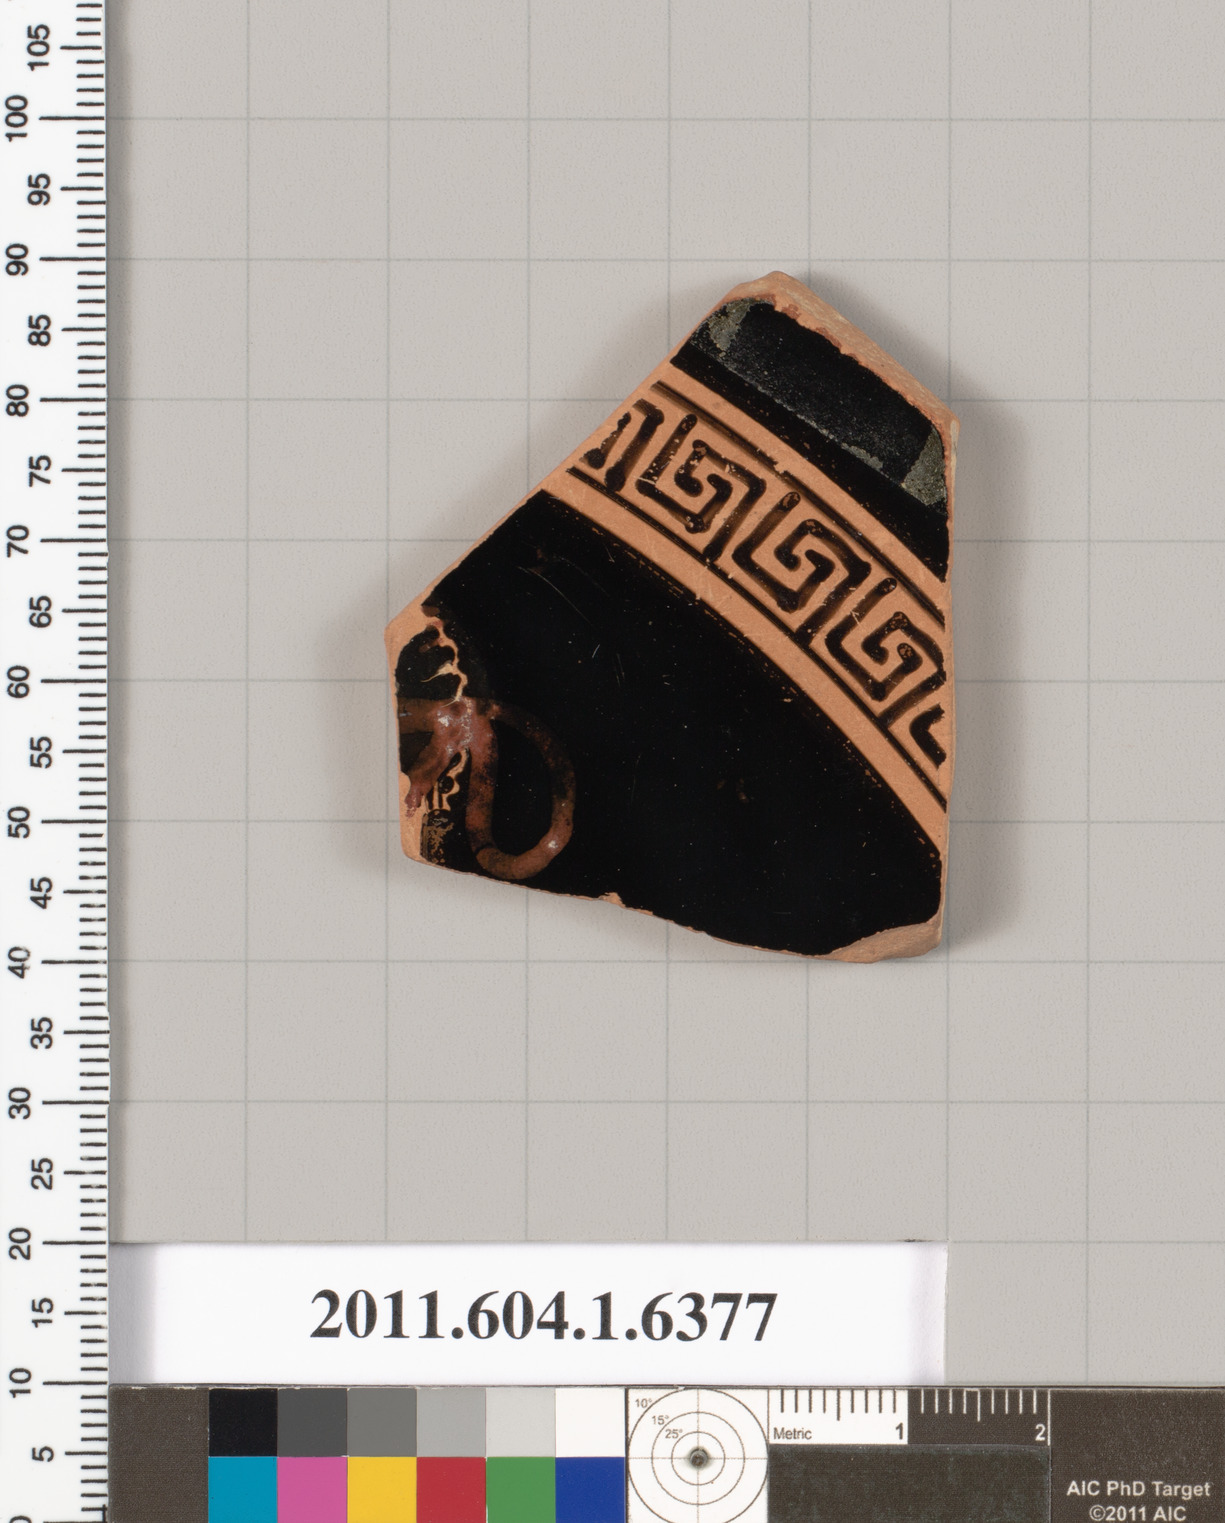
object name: kylix fragment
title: Terracotta fragment of a kylix (drinking cup)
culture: greek, attic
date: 490-480 BCE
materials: terracotta